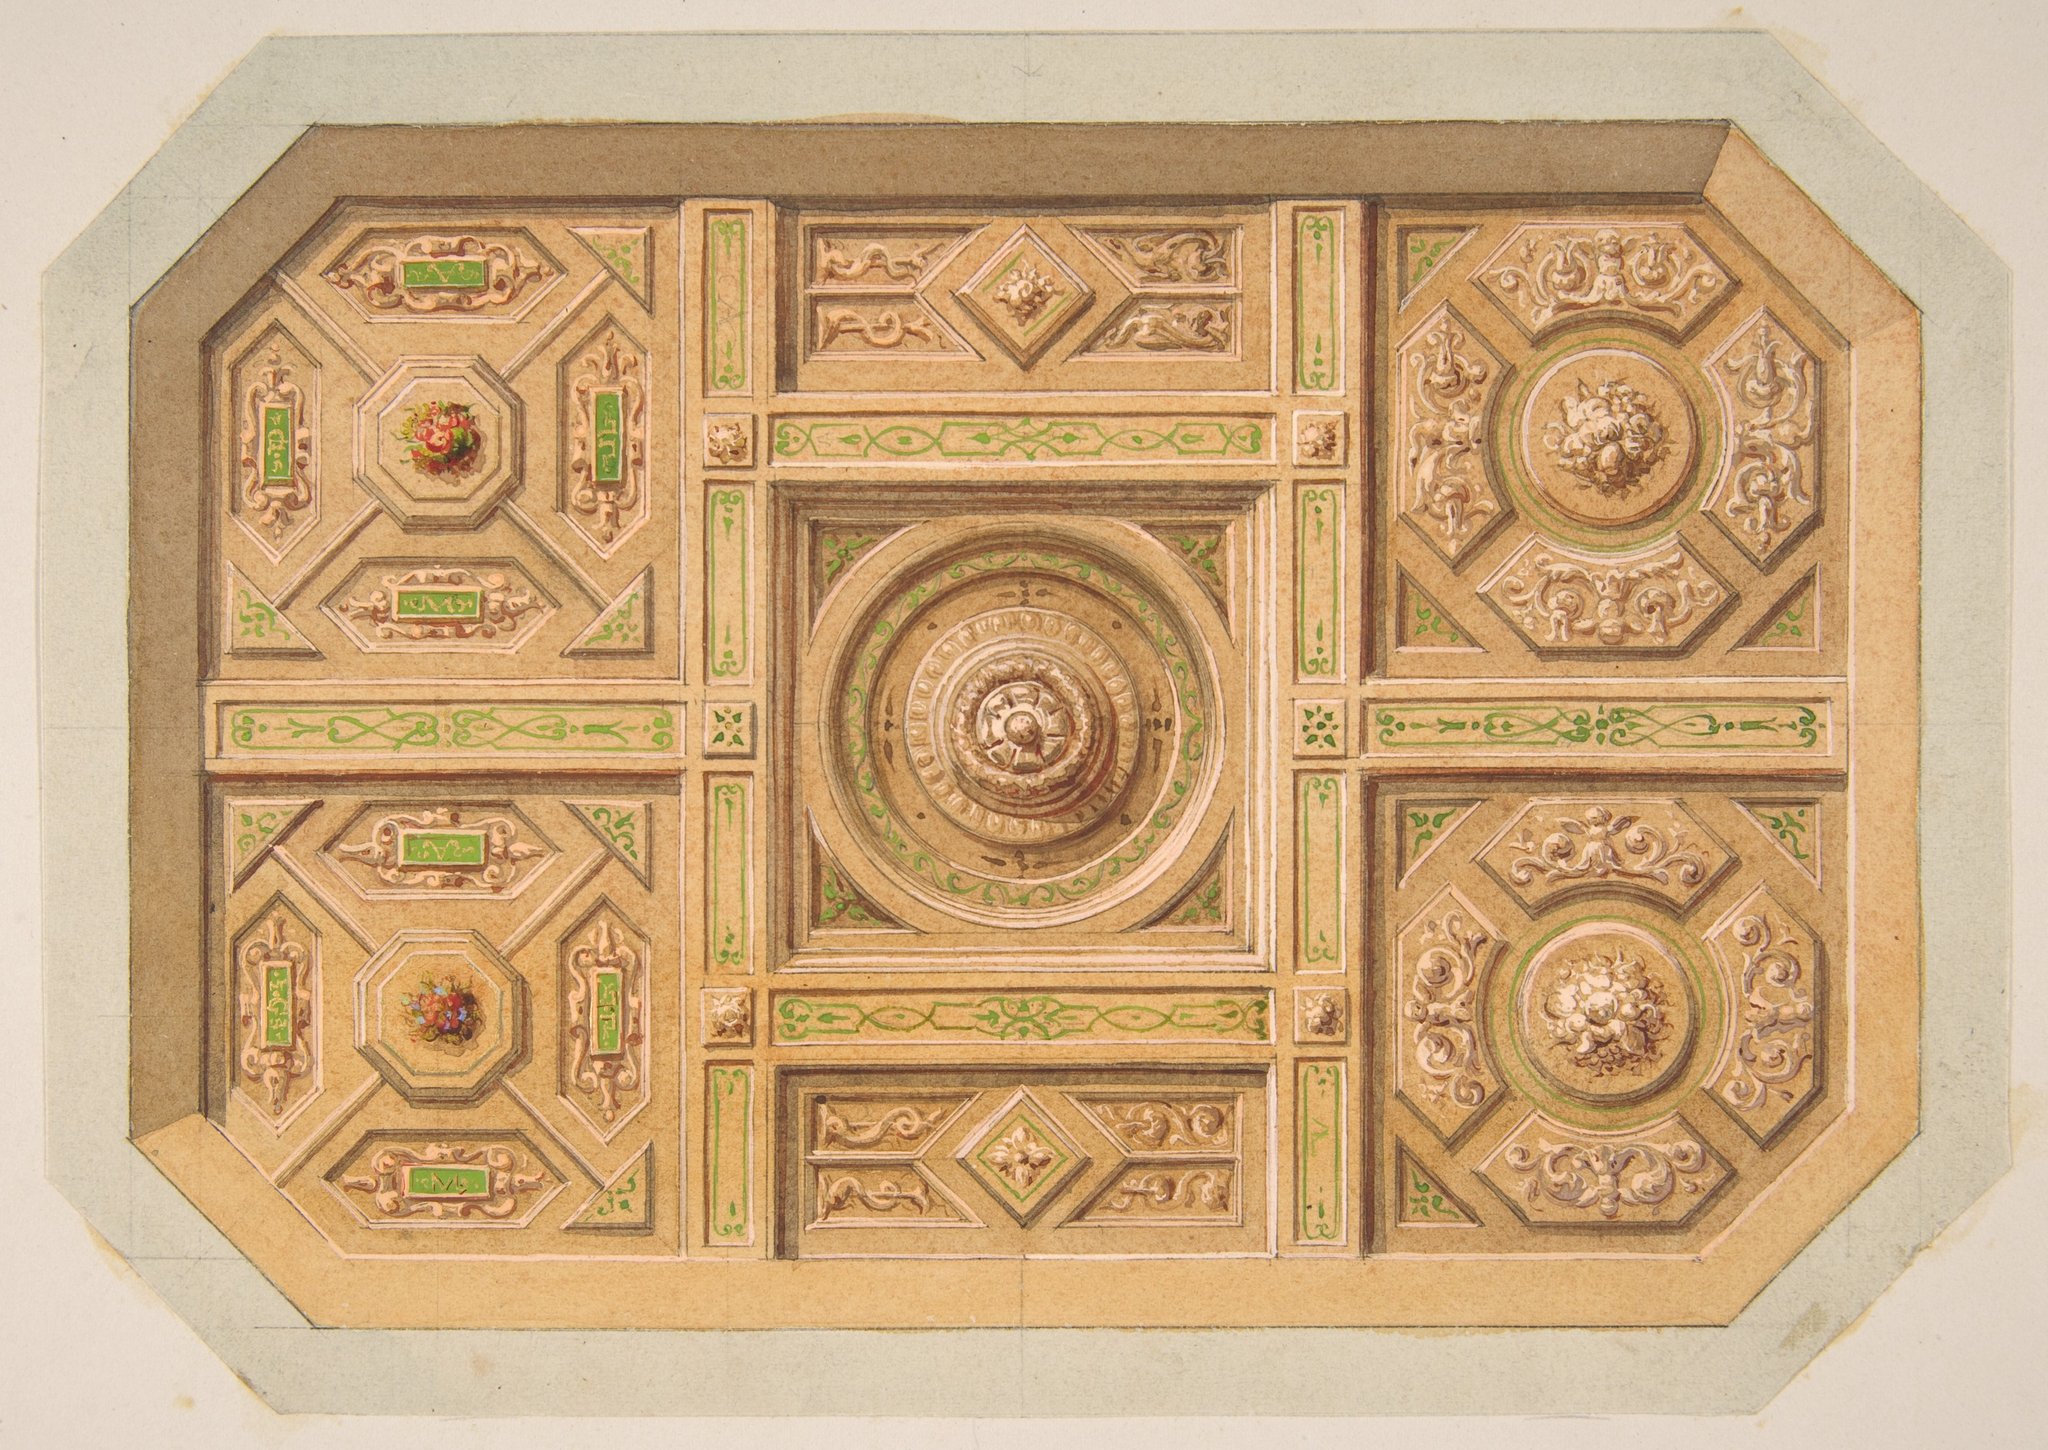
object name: drawing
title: Design for a paneled ceiling with painted decoration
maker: jules-edmond-charles lachaise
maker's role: artist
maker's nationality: french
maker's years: 1897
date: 1801-1900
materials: gouache, ink, watercolor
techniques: pen